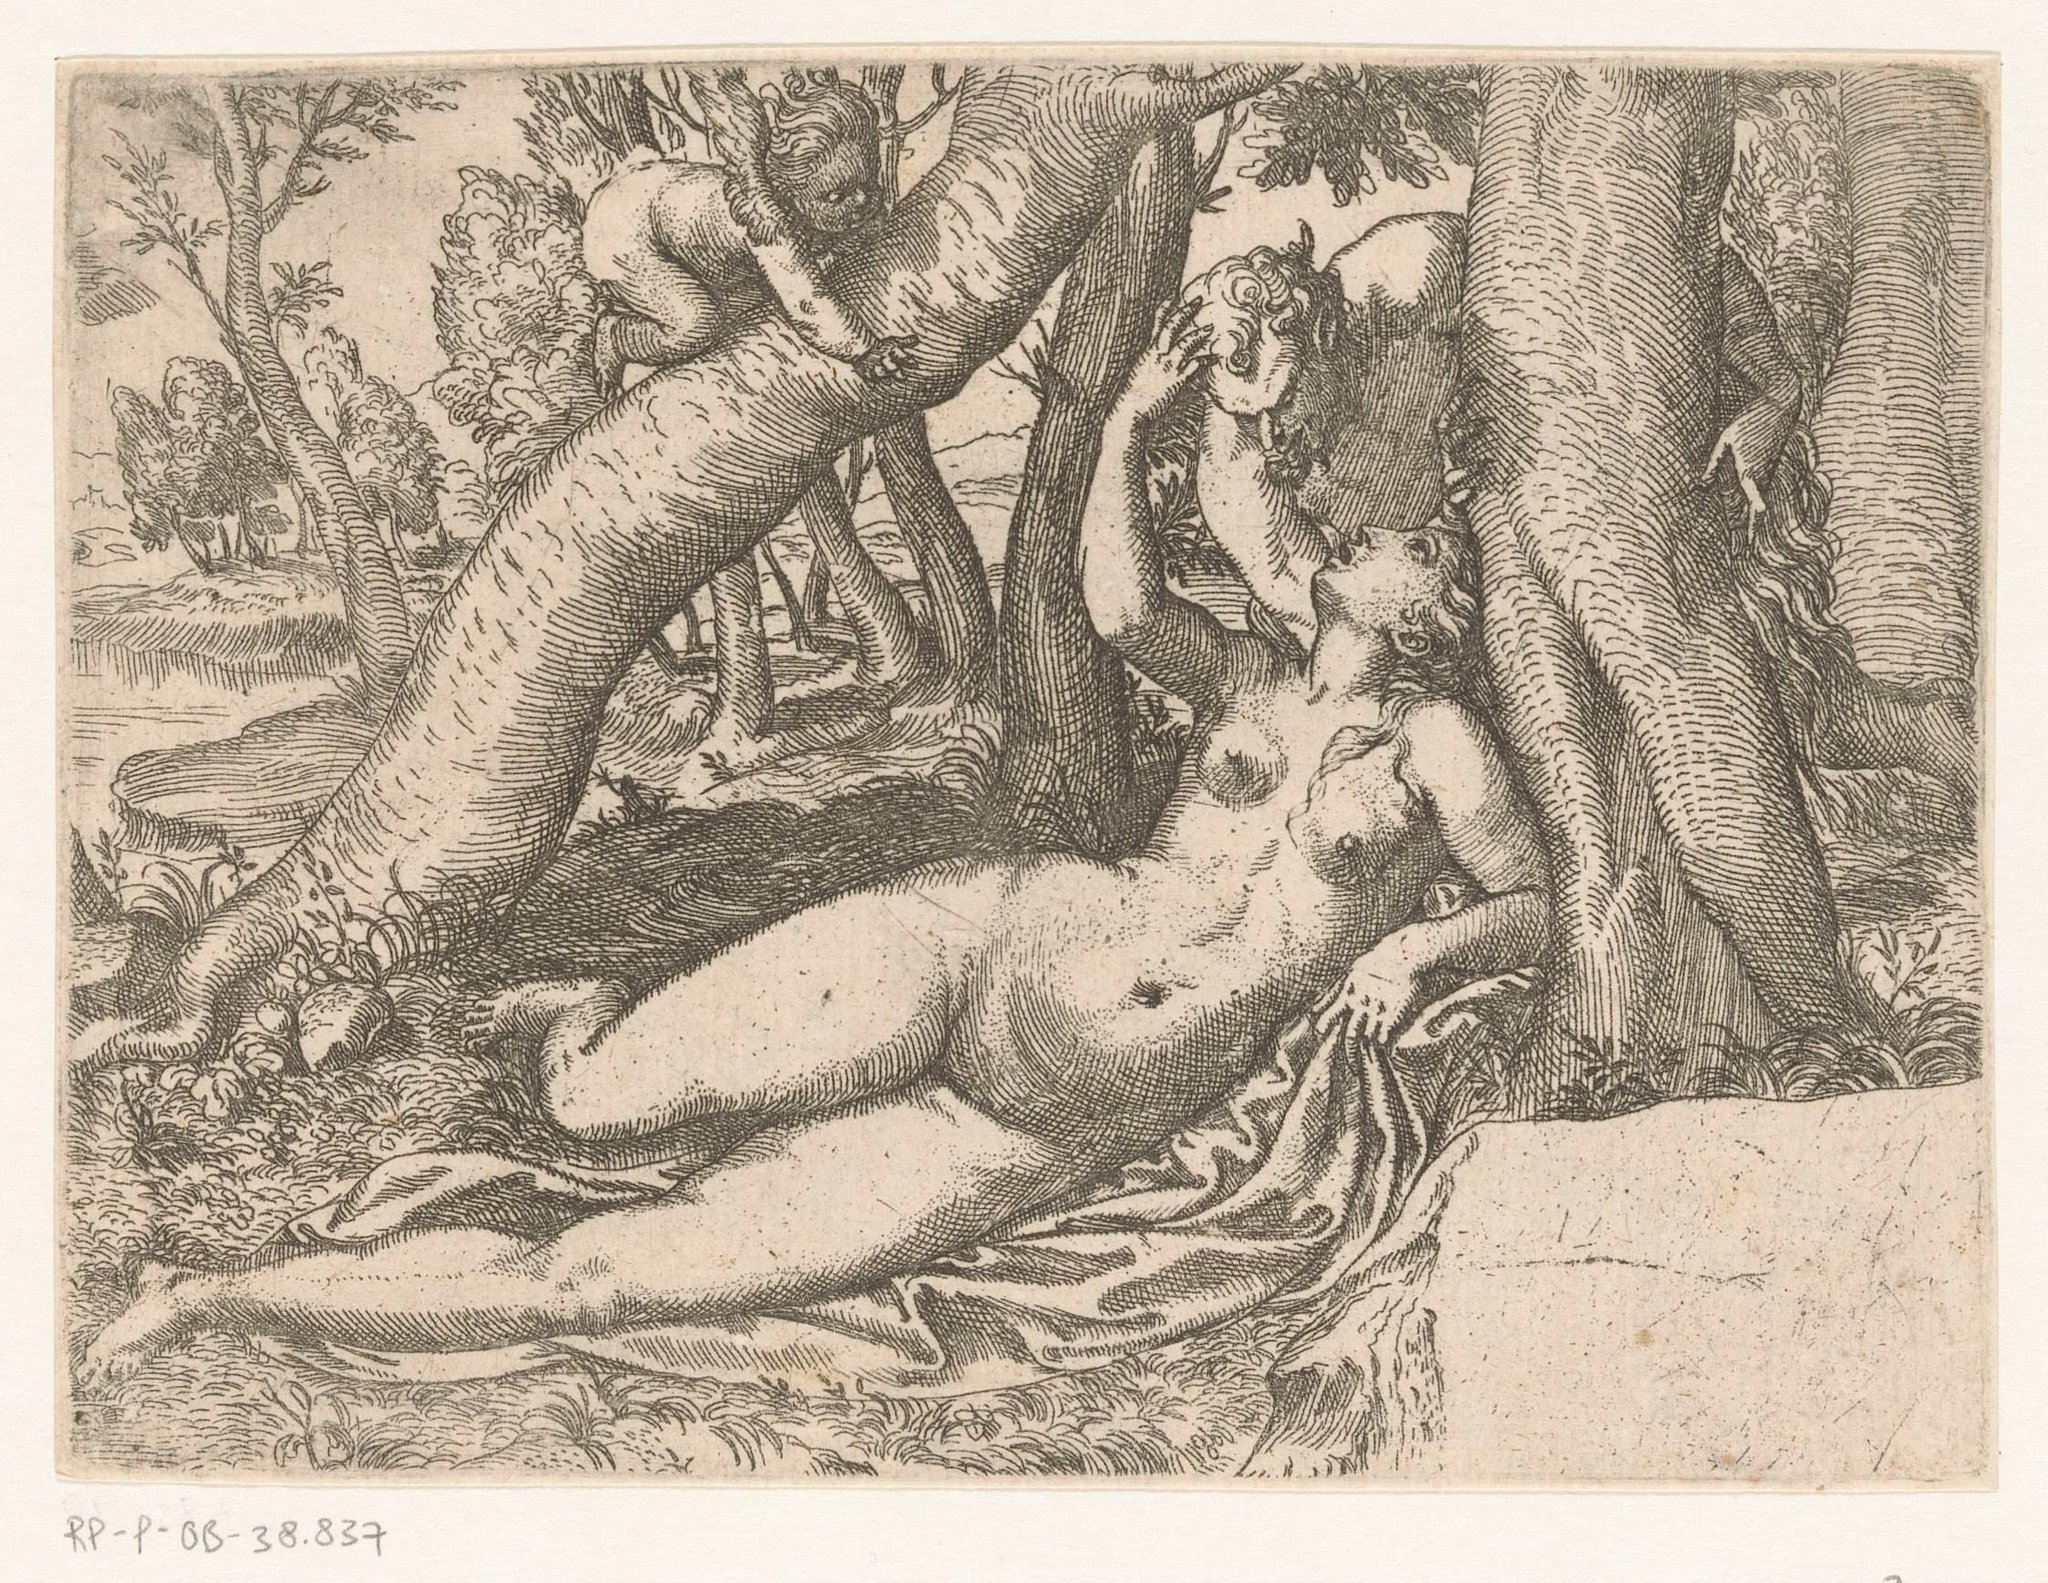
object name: print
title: Venus wordt gewekt door een sater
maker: Anonymous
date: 1550-1649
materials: paper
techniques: etching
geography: italy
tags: satyr(s) spying upon, venus and cupid (cupid not being mere attribute)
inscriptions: collector's mark: Lugt 240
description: In een boslandschap ligt de naakte Venus. Achter Venus staat een sater die haar uit haar slaap heeft laten ontwaken. Links vliegt Amor naast een boom.